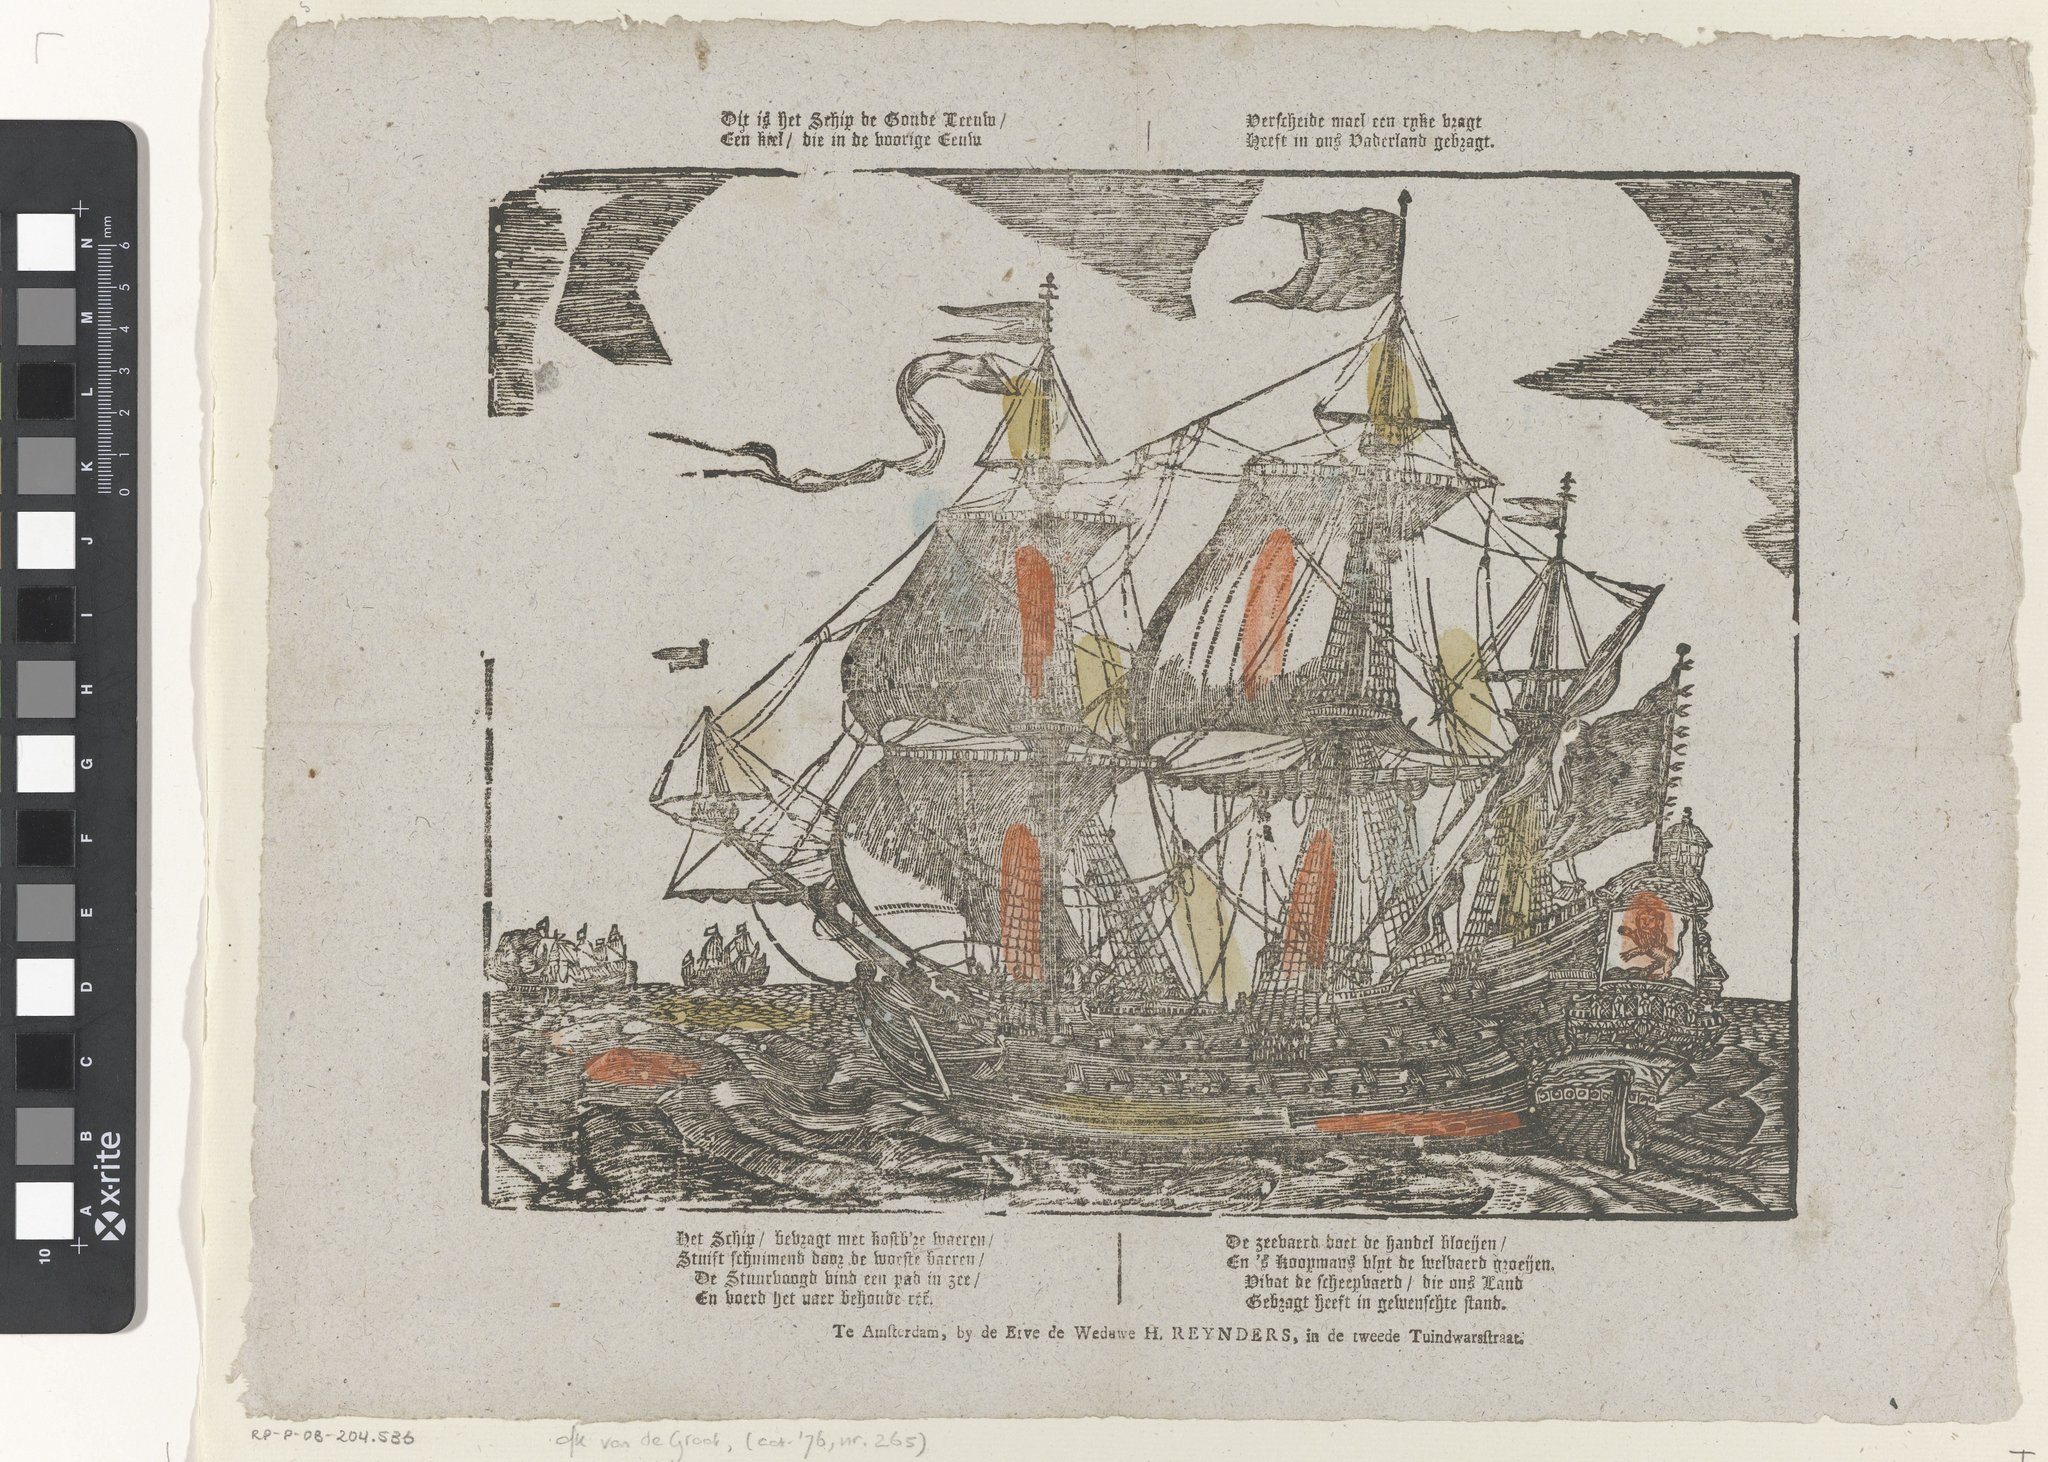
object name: print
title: Dit is het schip de Goude Leeuw / Een kiel / die in de voorige eeuw / Verscheide mael een ryke vragt / Heeft in ons vaderland gebragt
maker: Anonymous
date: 1781-1831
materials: paper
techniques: colour, letterpress printing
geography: amsterdam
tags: ships (in general)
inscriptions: collector's mark: Lugt 2760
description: Blad met een grote voorstelling van het zeilschip de Gouden Leeuw op zee. Onder de afbeelding een achtregelig vers in twee kolommen.